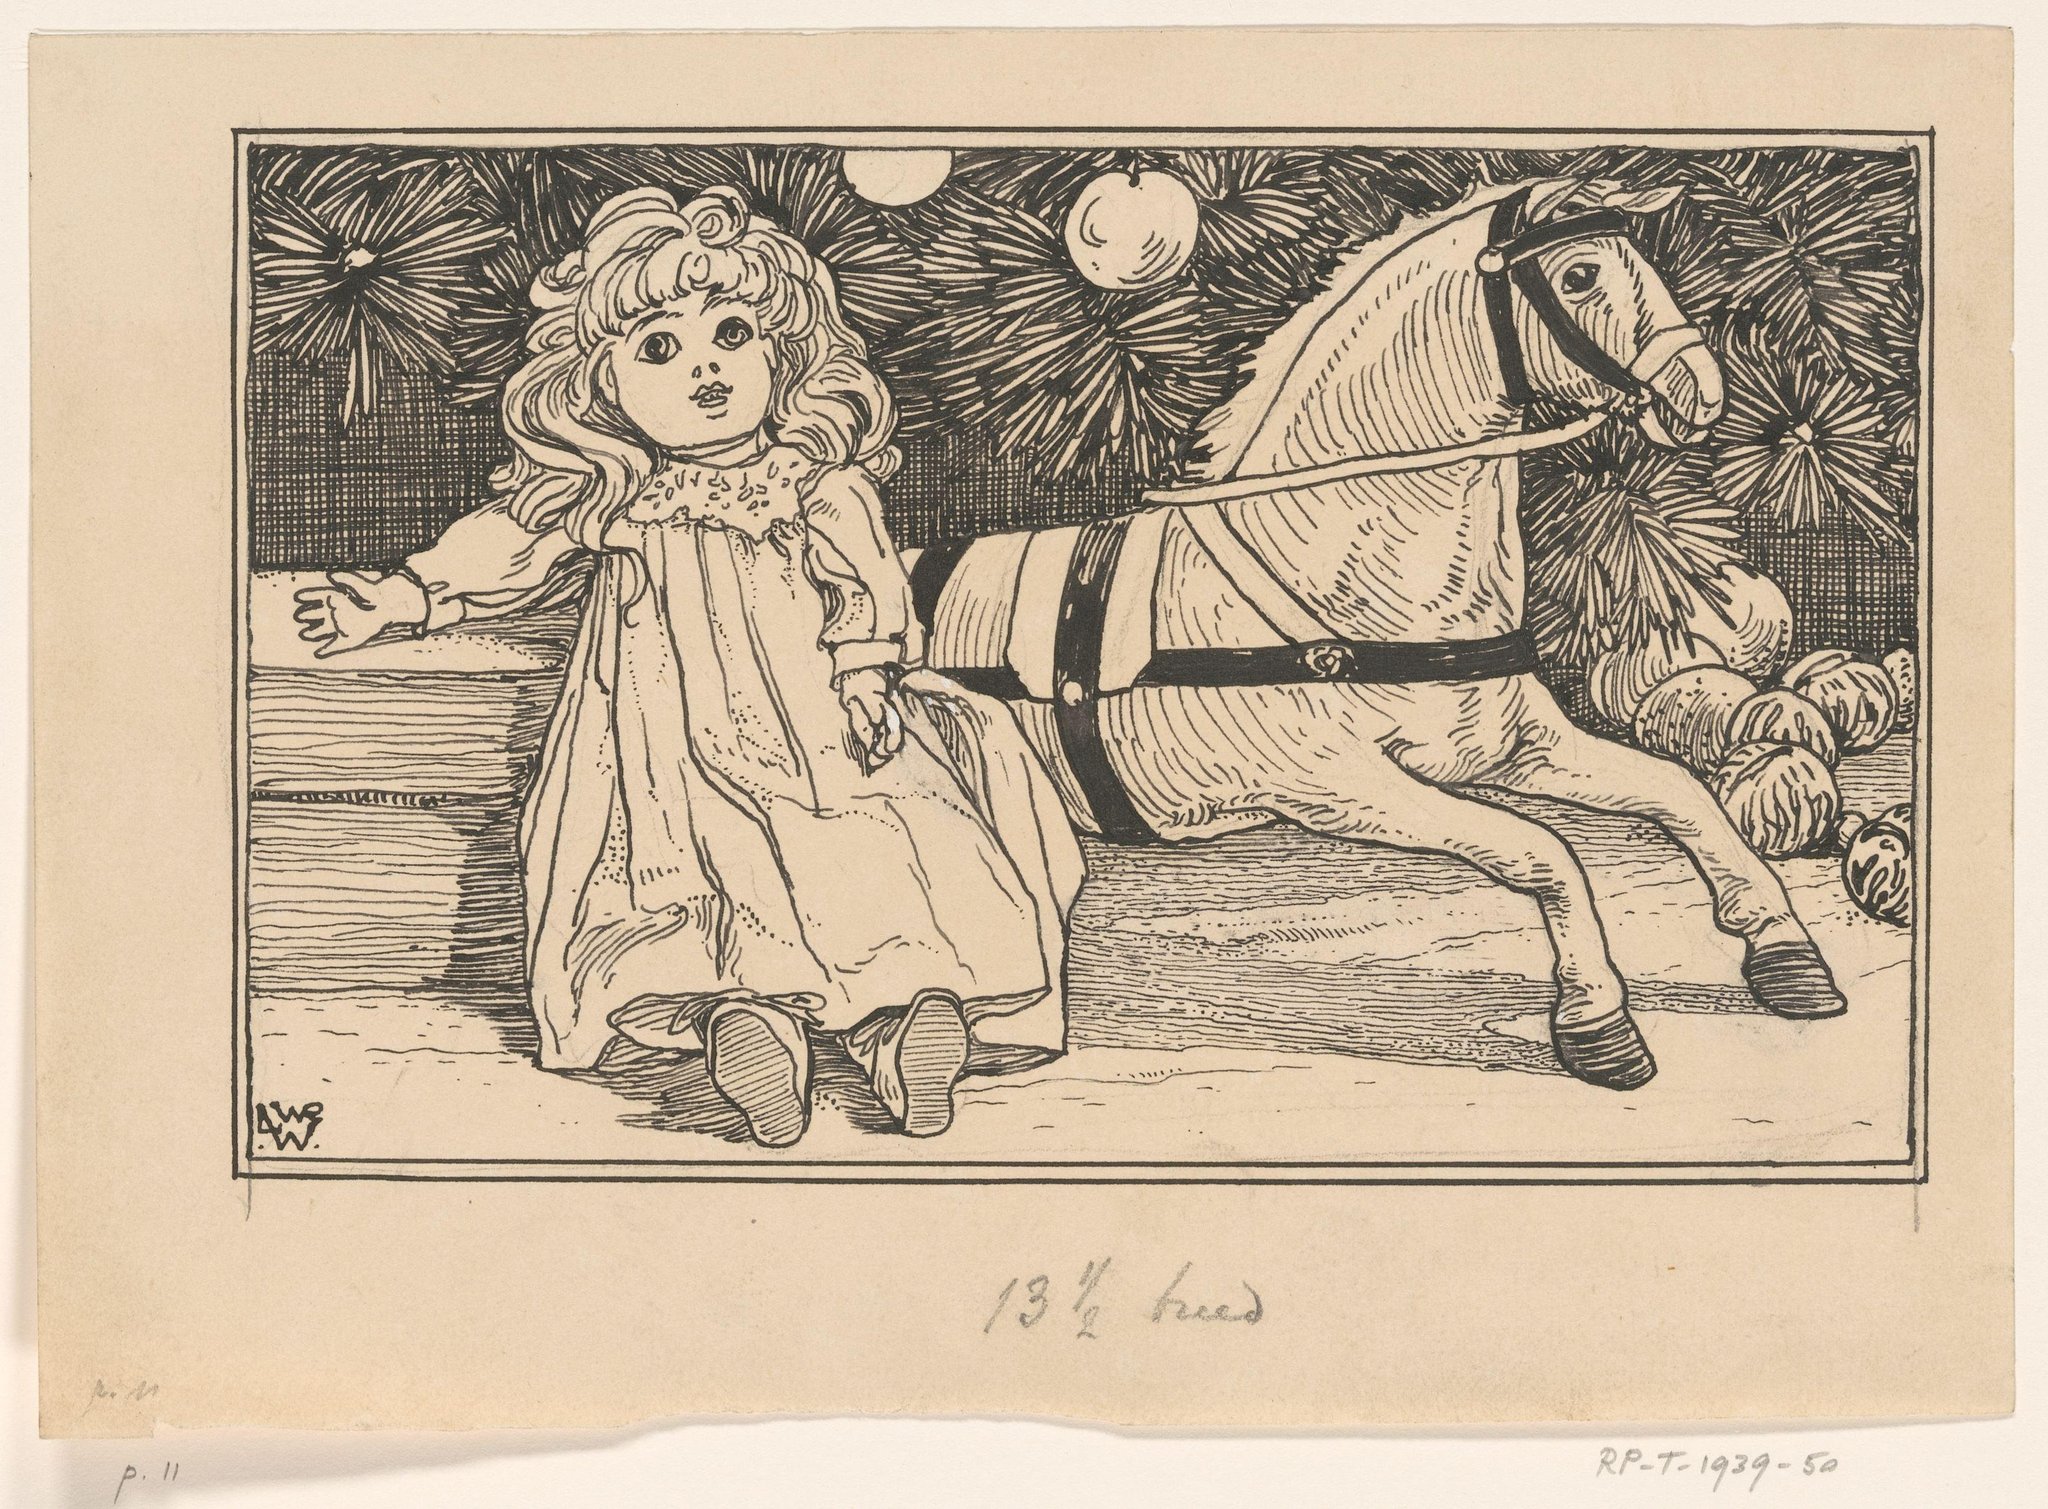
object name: boekillustratie ontwerp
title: Pop en speelgoedpaard onder een kerstboom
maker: willem wenckebach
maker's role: designer, draughtsman, painter, print maker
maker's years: 1860-1937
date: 1898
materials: paint, ink, paper, pencil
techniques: brush, pen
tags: christmas tree, (playing with) dolls, toy animals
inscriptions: inscription: ‘p. 11’, collector's mark: Lugt 2228a, :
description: Ontwerp voor: Hoffman, Ernst Theodor Amadeus. Notenkraker en muizenkoning. Amsterdam: Scheltema & Holkema, 1898.